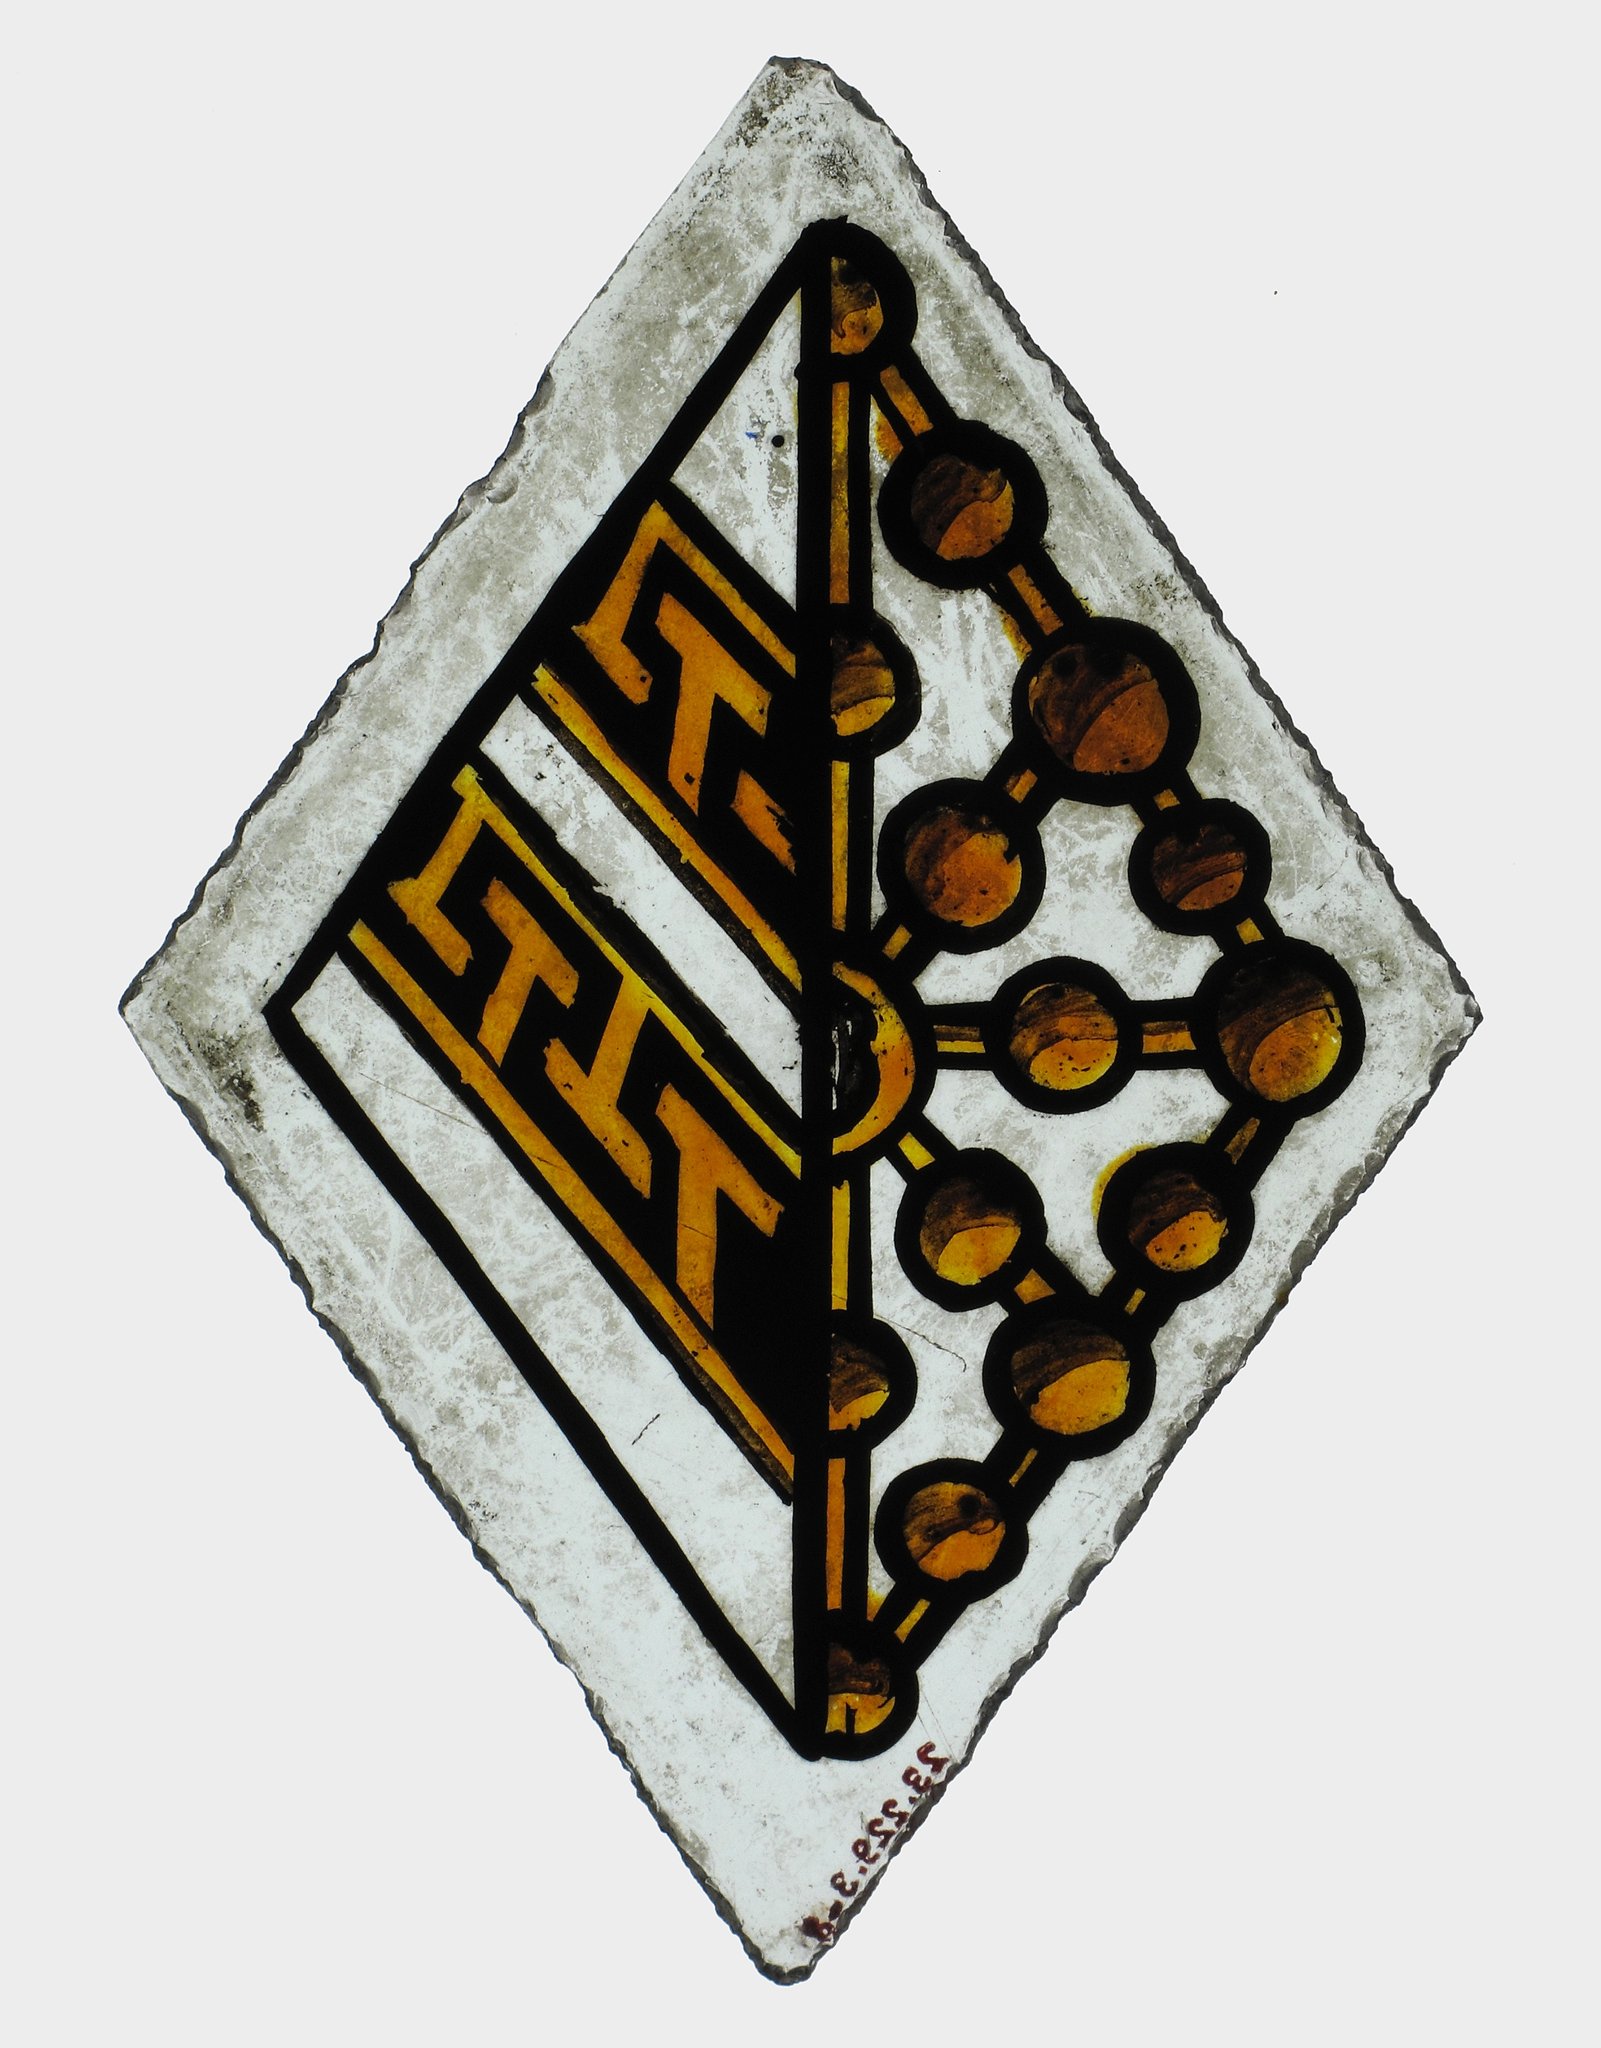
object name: fragment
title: Glass Fragment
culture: french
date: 1601-1700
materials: glass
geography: france